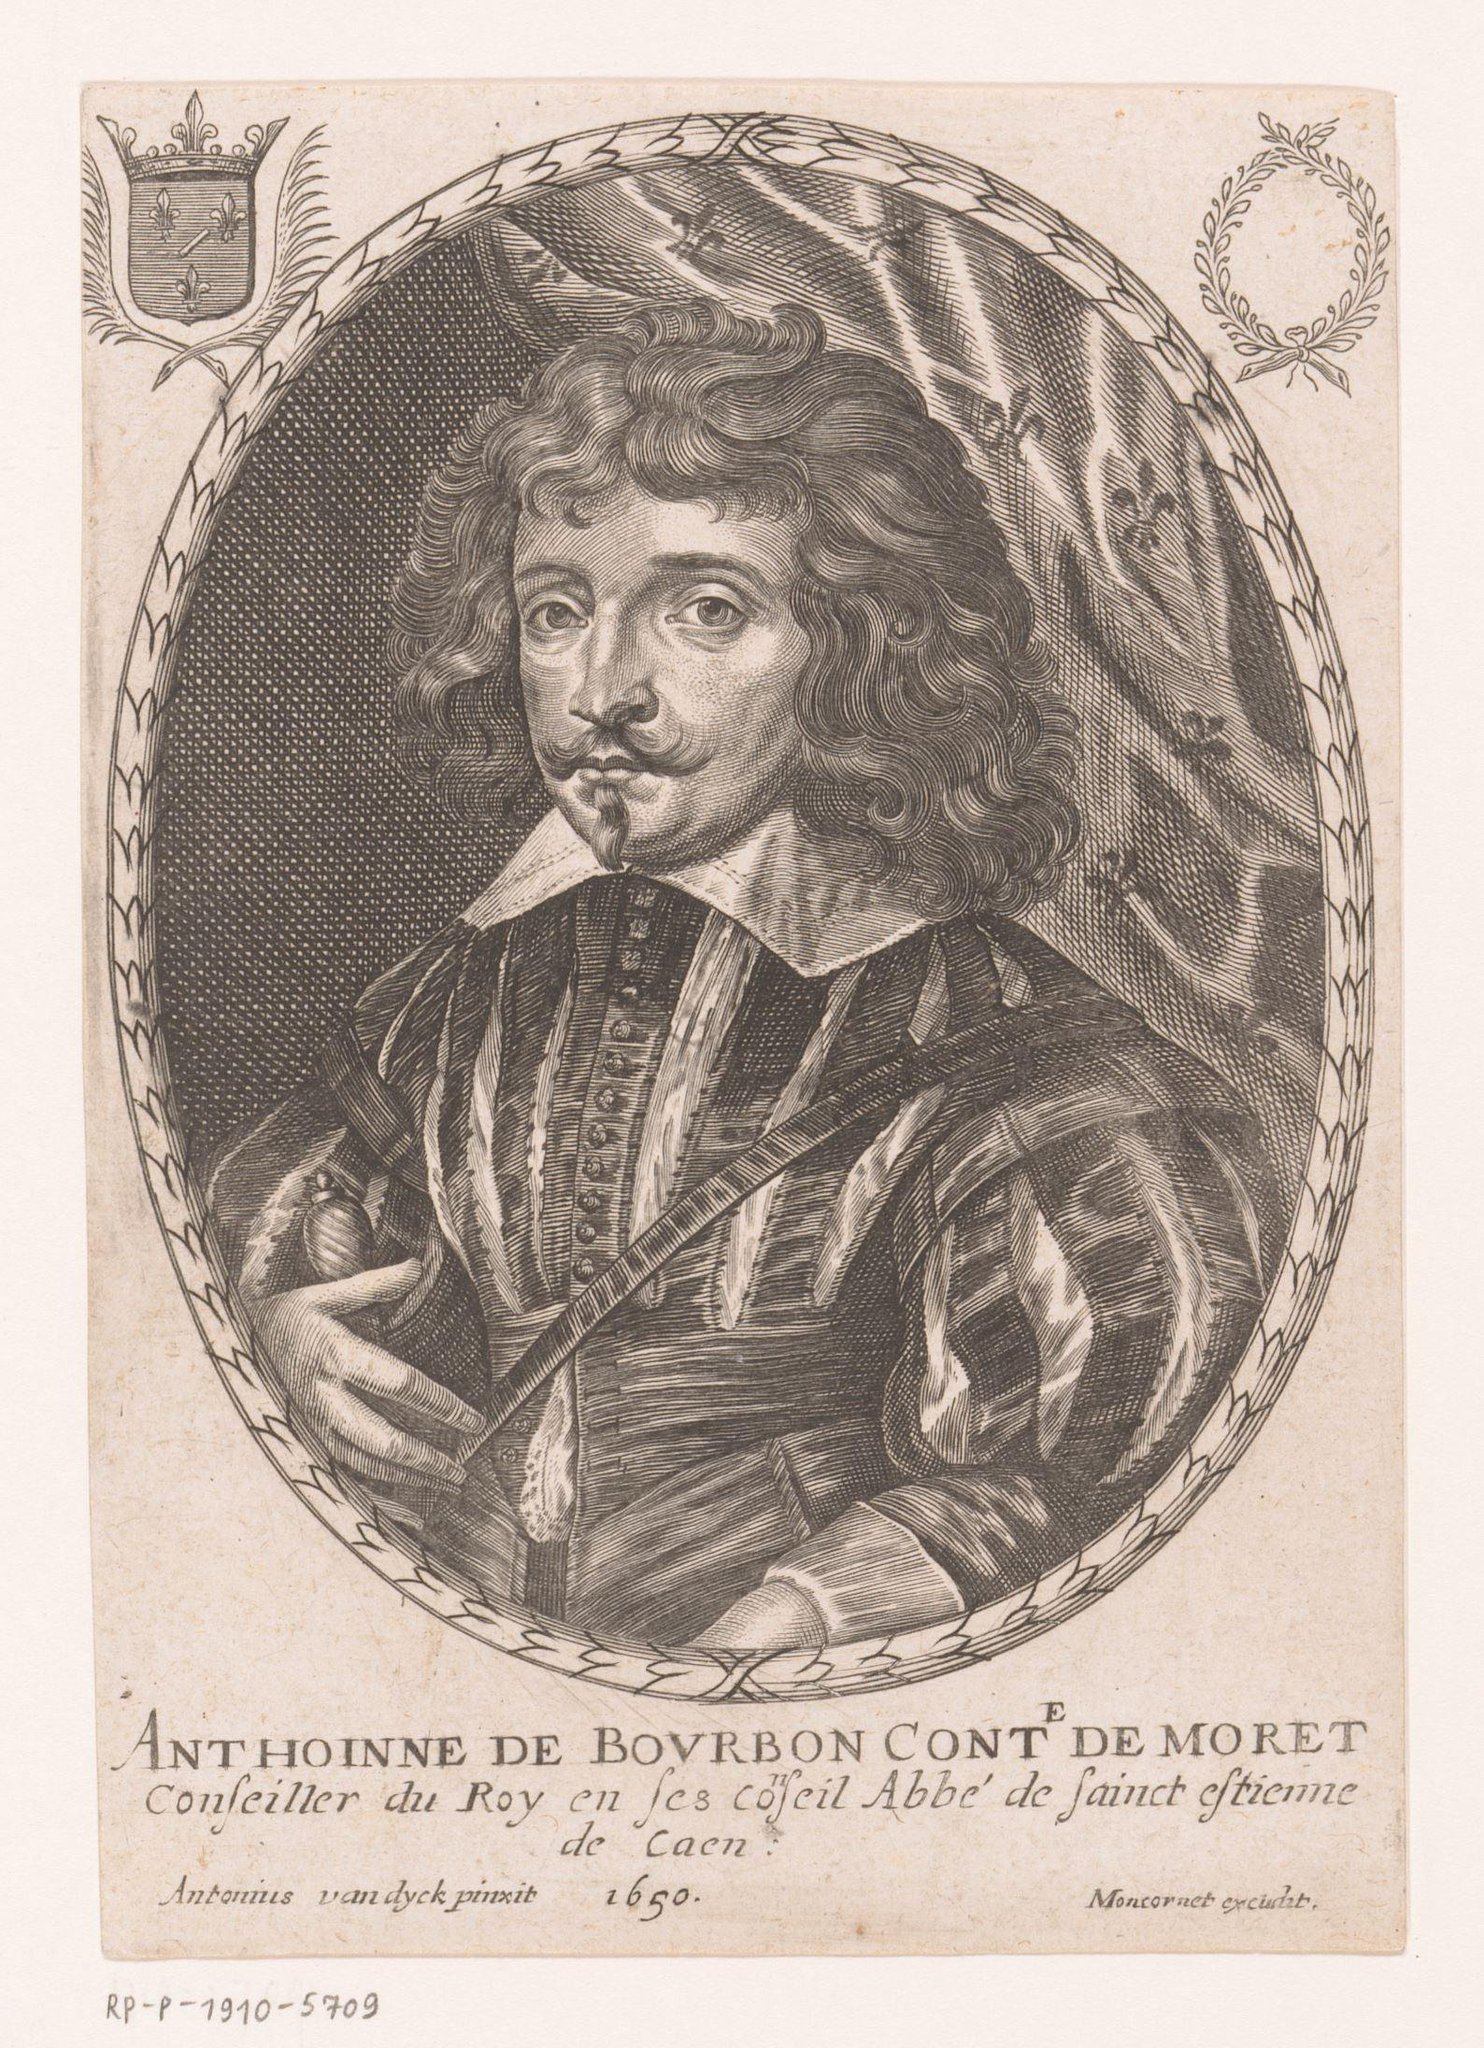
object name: print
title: Portret van Antoine de Bourbon-Bueil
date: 1650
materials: paper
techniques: engraving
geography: paris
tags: antoine de bourbon (graaf van moret), historical persons, armorial bearing, heraldry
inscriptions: collector's mark: Lugt 2228